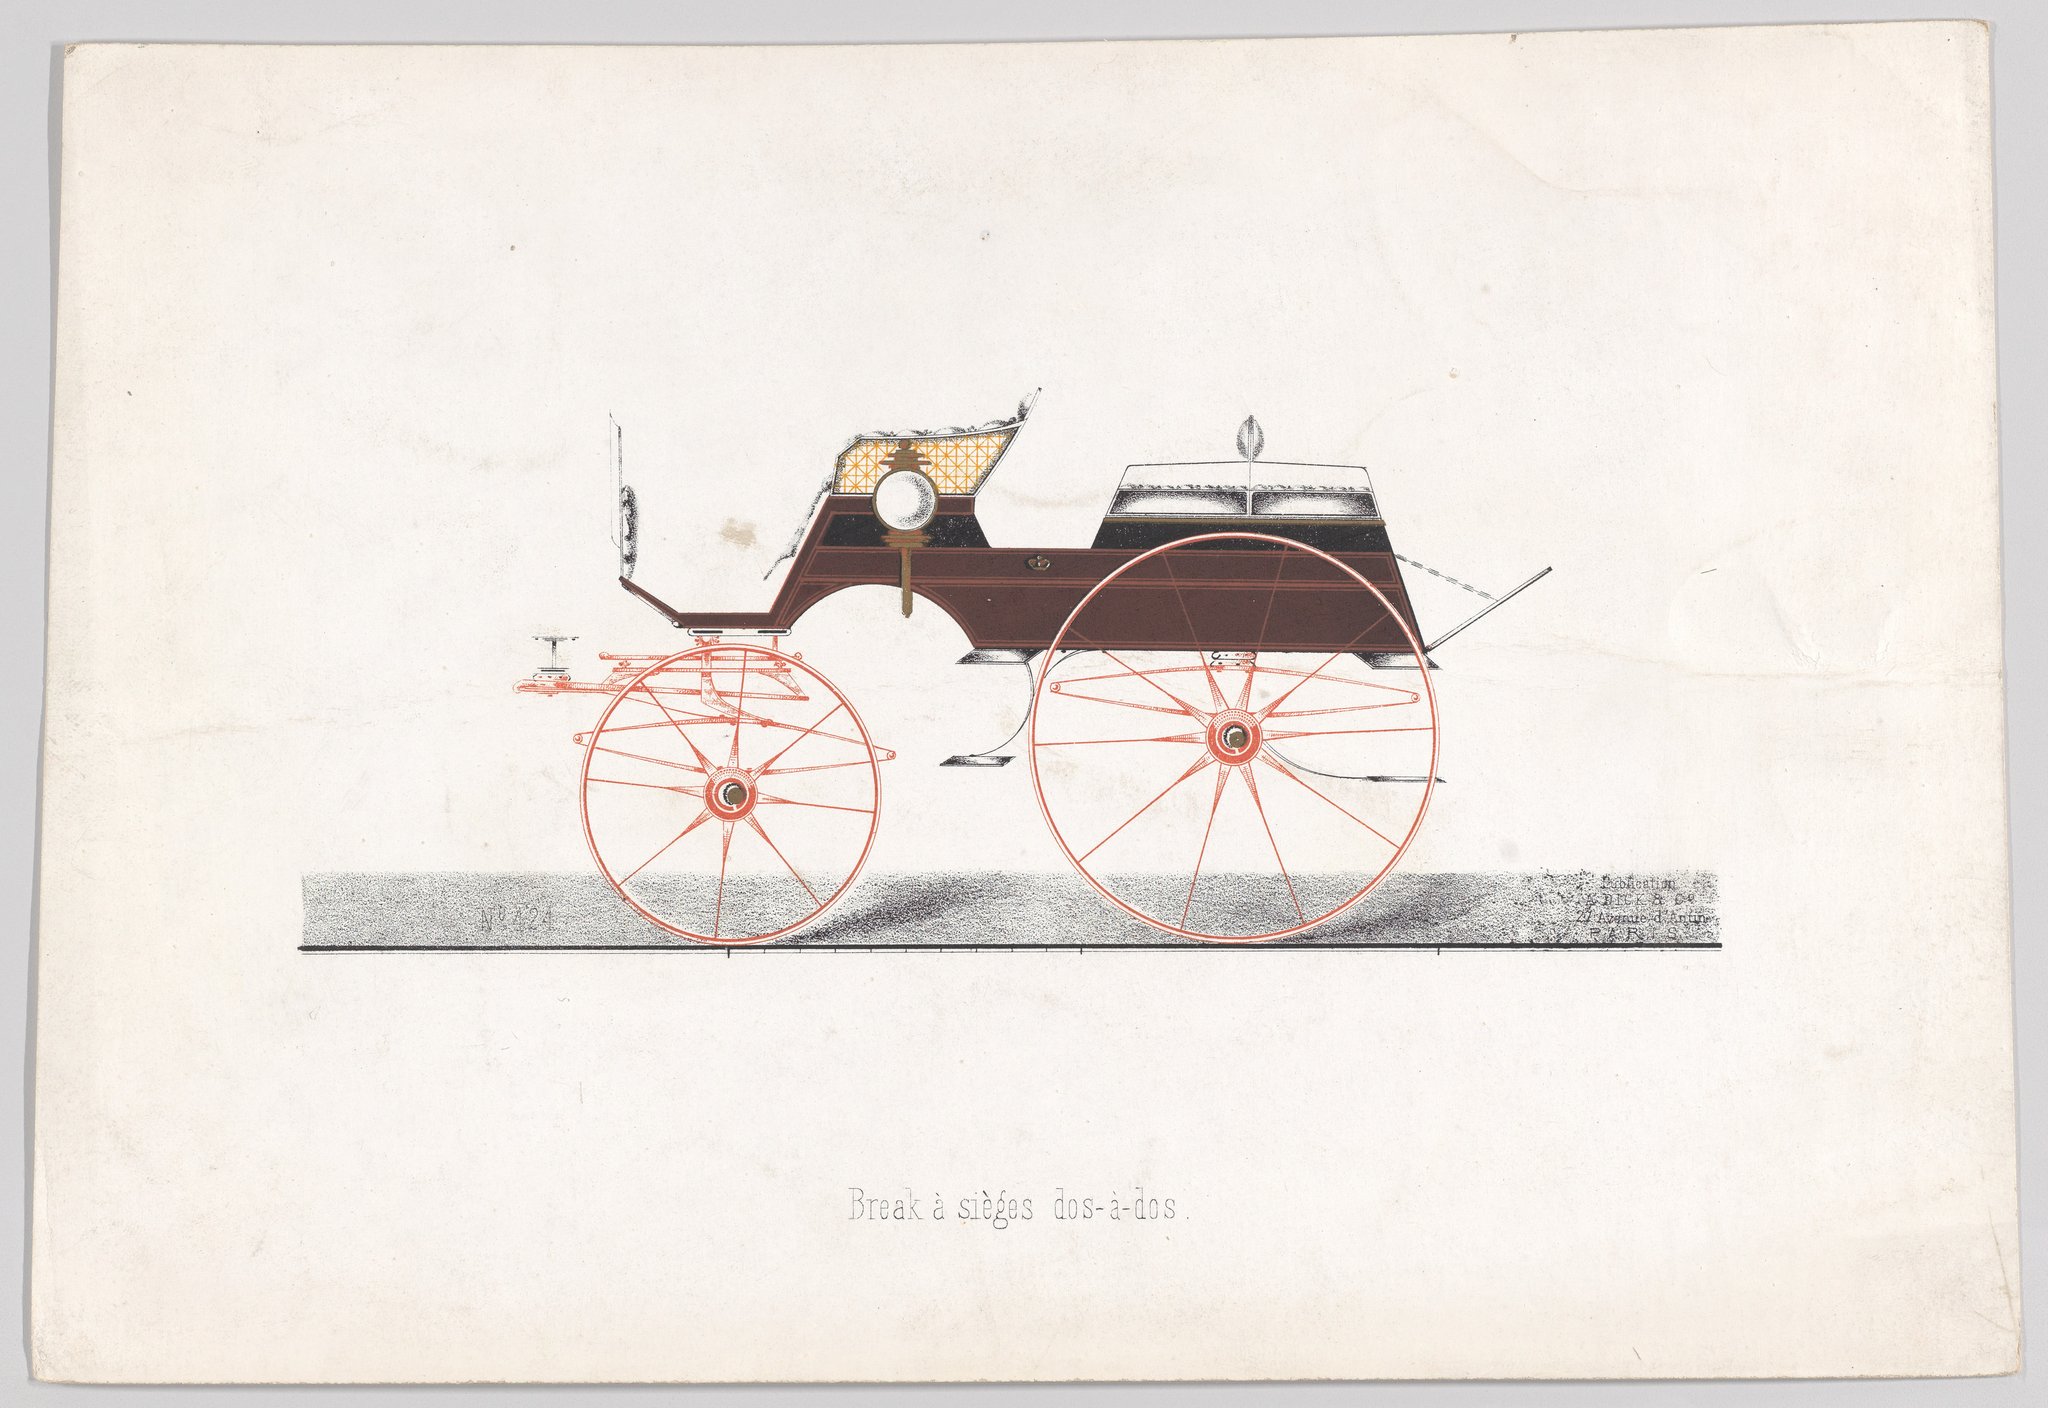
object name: print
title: Design for Dos-A-Dos Phaeton Carriage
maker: anonymous, french, 19th century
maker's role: artist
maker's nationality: french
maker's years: 1800-1900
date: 1870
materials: gum arabic, ink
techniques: hand coloring, lithograph, printing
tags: carriages